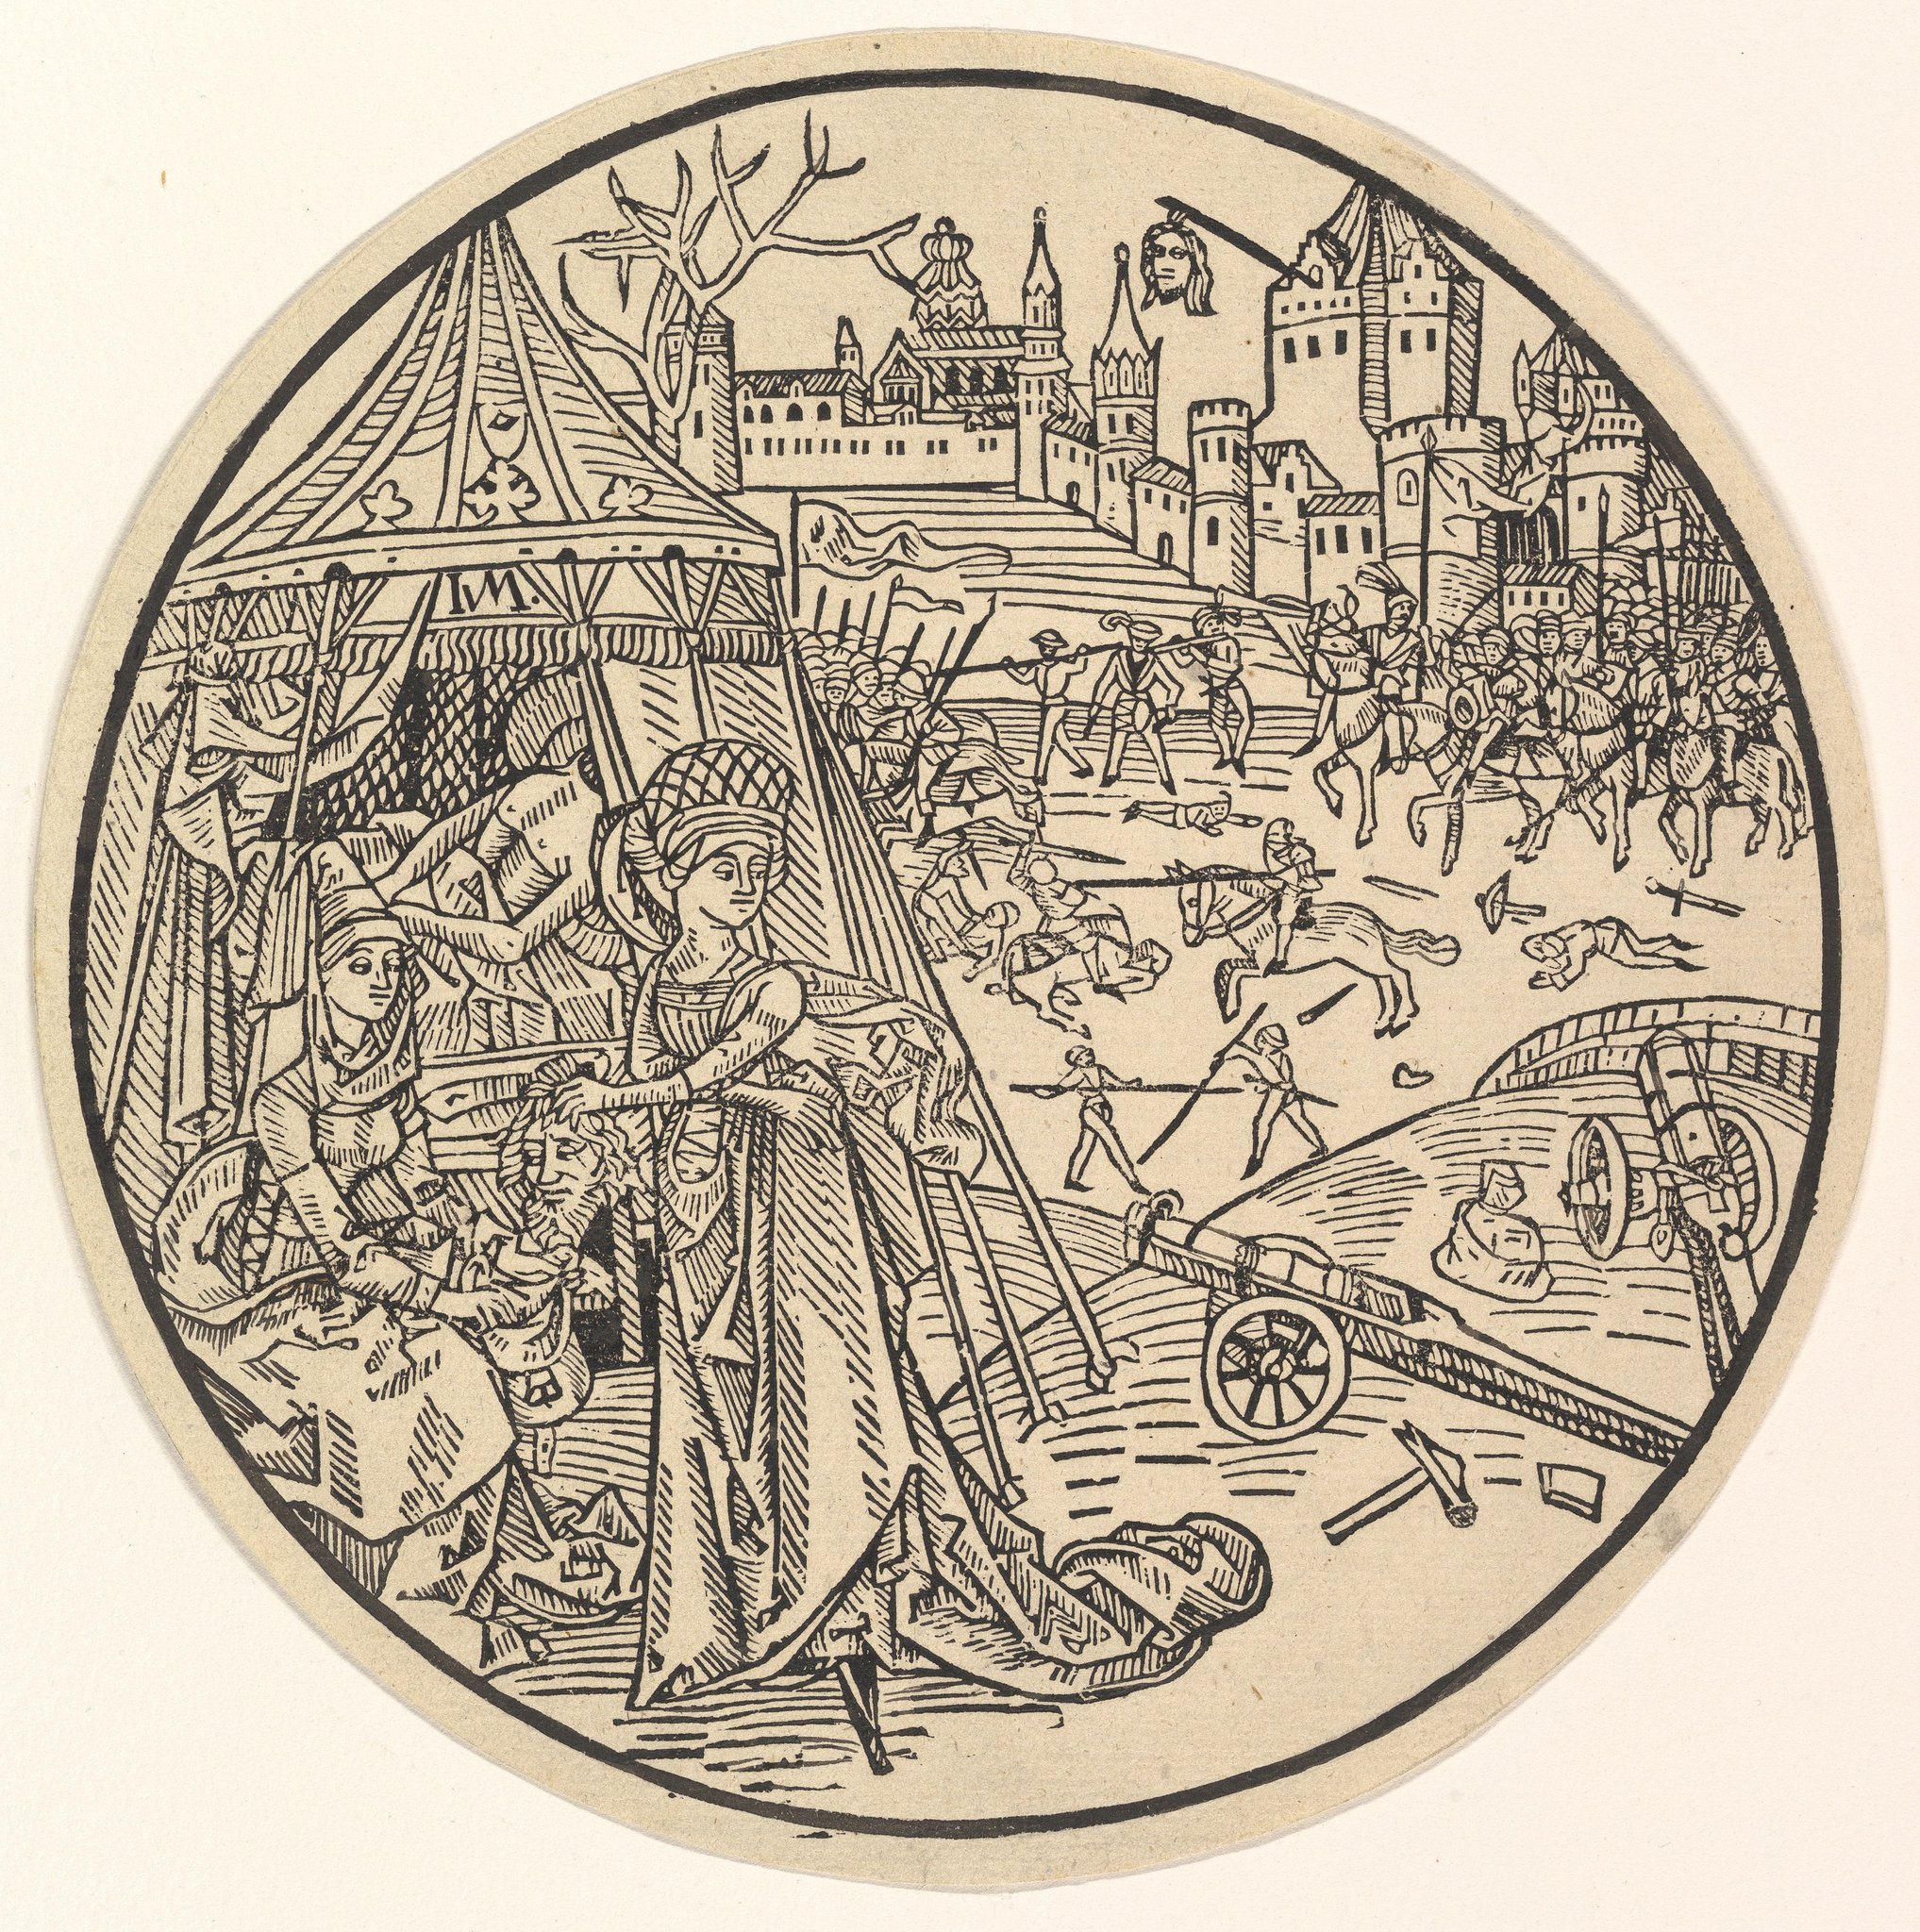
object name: print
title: Judith with the Head of Holofernes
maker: israhel van meckenem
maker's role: artist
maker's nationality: german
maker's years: 1435-1503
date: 1440-1600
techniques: woodcut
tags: heads,women,horses,holofernes,judith